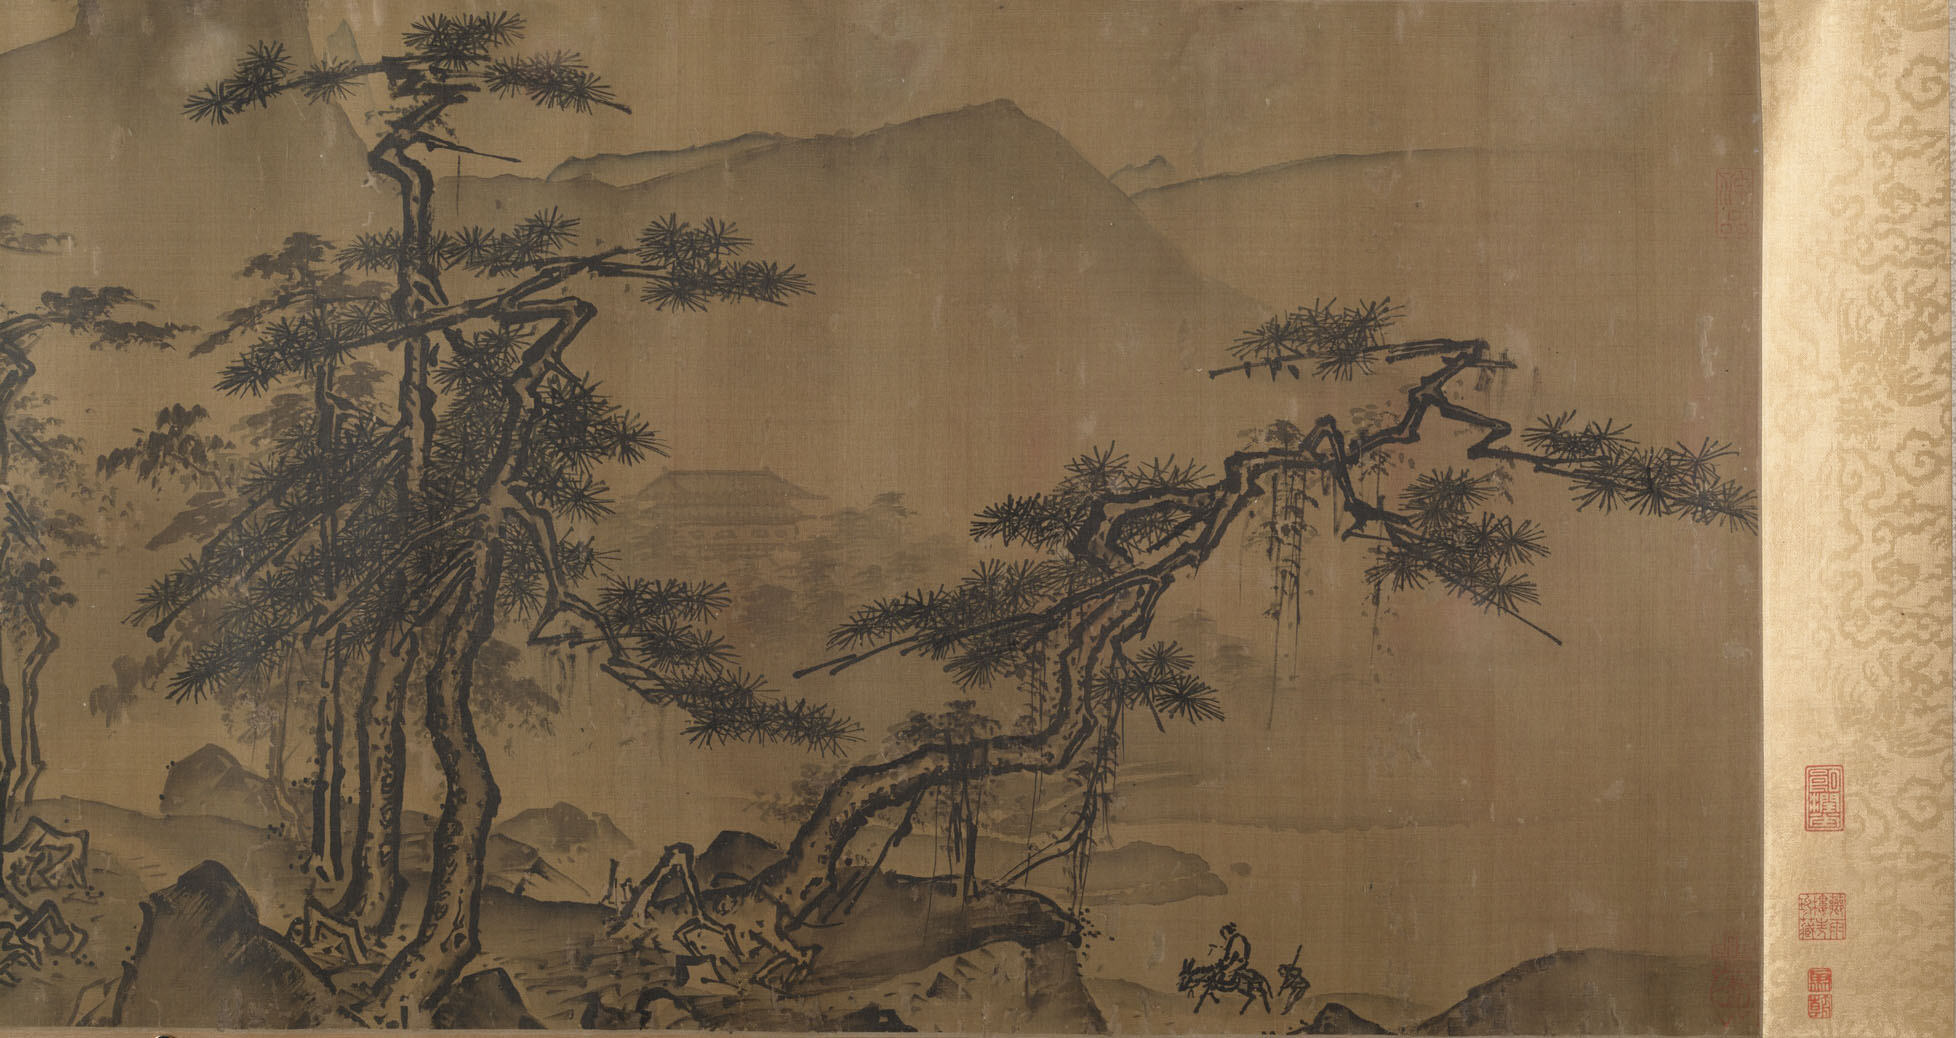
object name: handscroll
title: Landscape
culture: chinese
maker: unidentified artist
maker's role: artist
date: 1644-1911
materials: ink, silk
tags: mountains,landscapes,trees